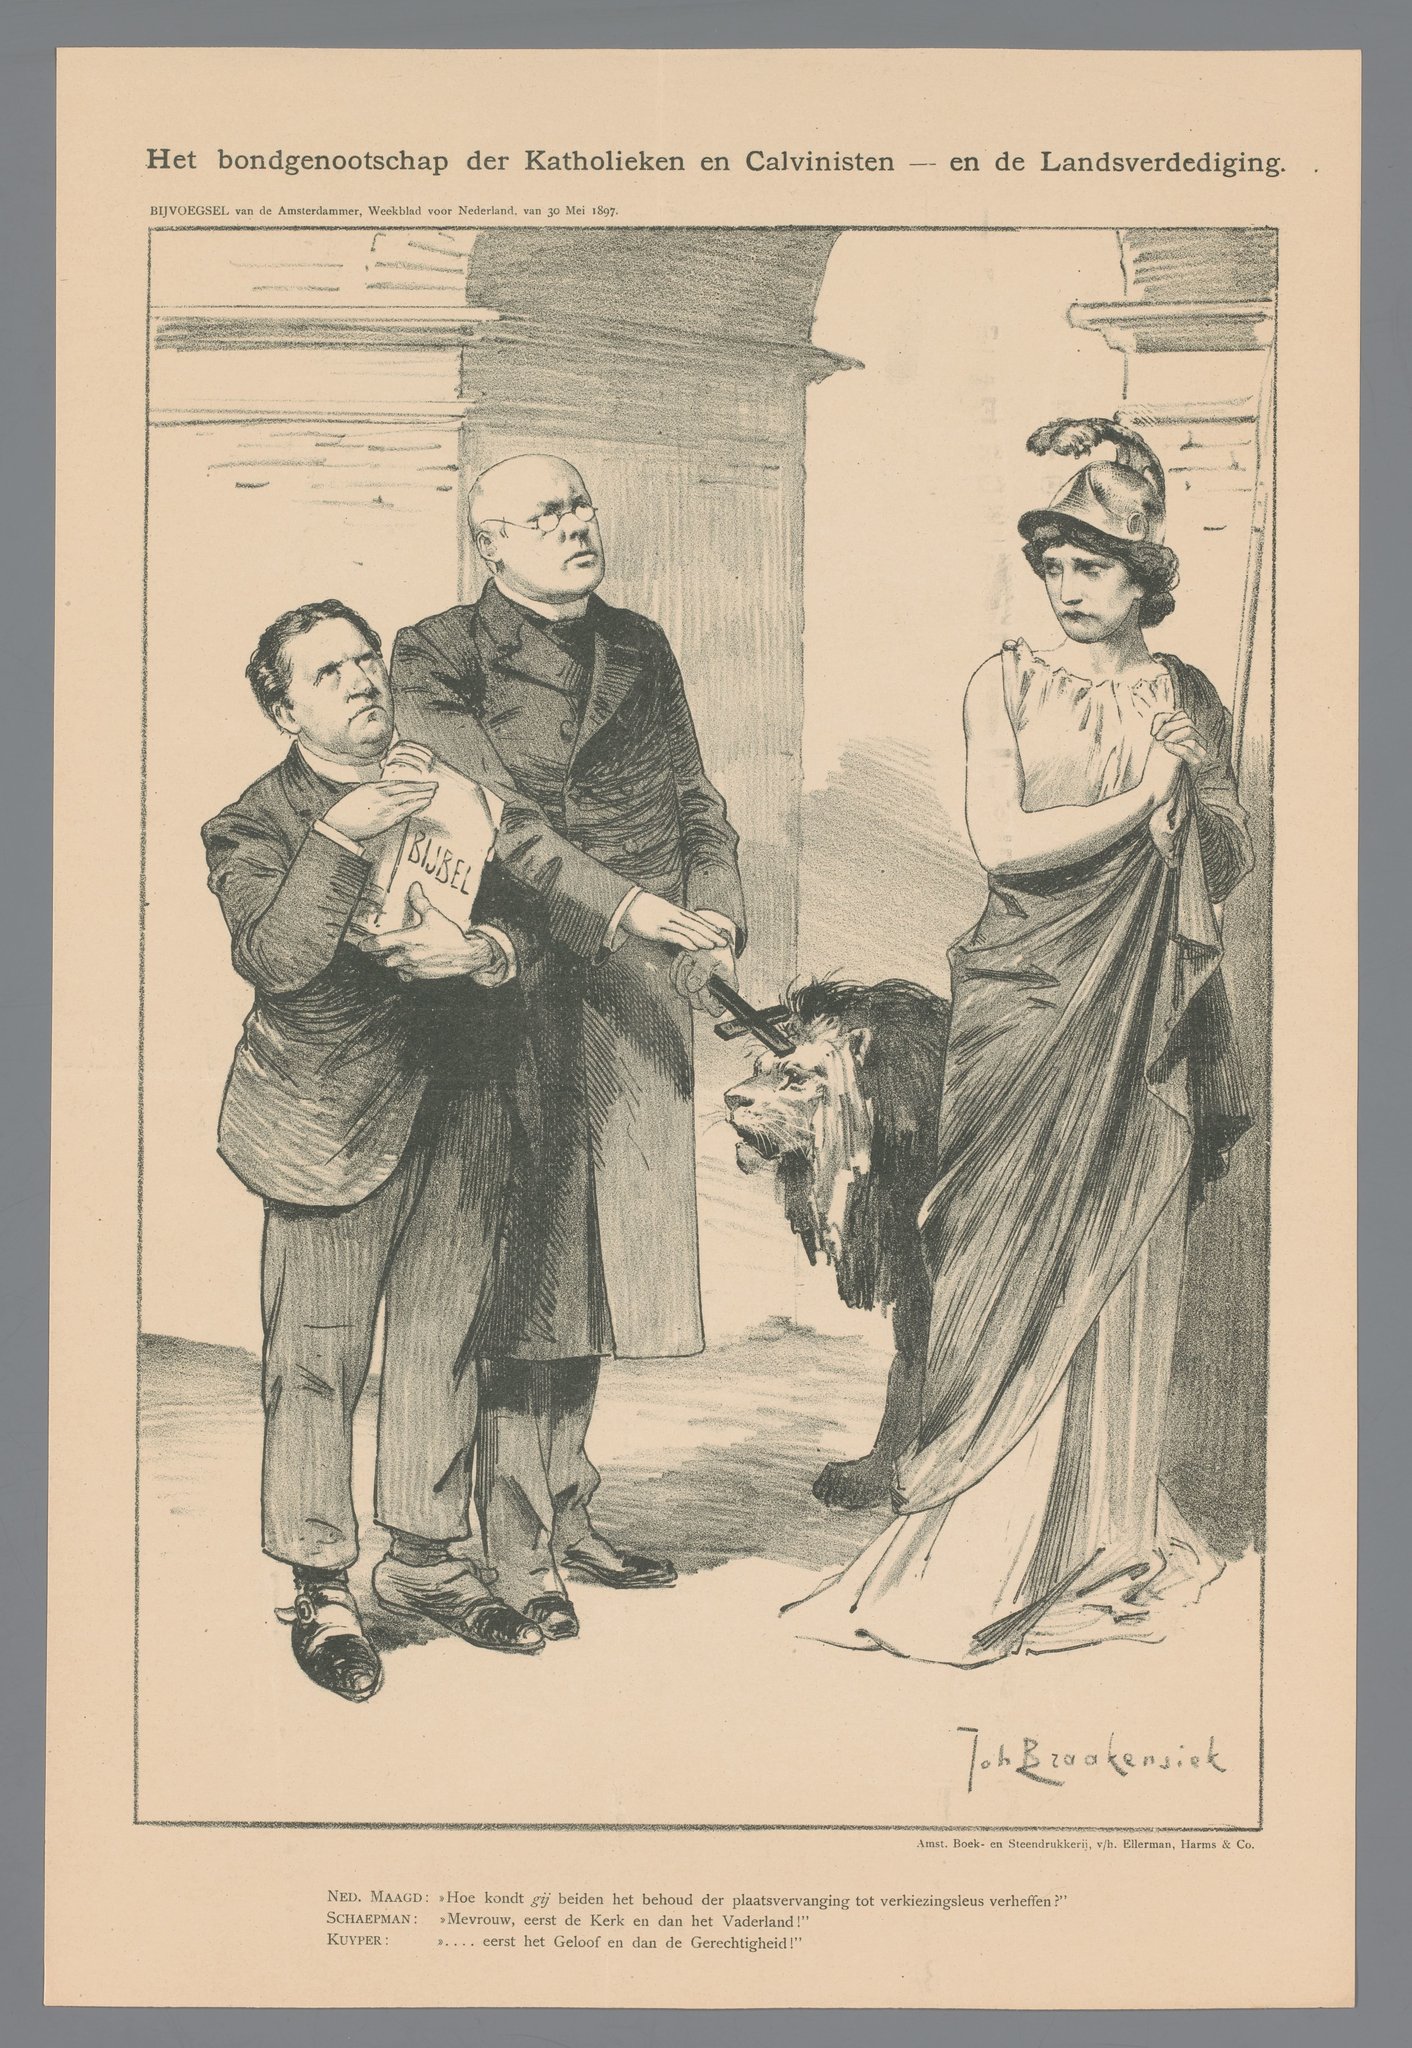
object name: cartoon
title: Het bondgenootschap der Katholieken en Calvinisten - en de Landsverdediging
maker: johan braakensiek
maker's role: draughtsman, print maker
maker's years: 1858-1940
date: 1897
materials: paper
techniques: lithograph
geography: amsterdam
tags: the hague, abraham kuyper, rome, priest, herman johannes aloysius maria schaepman, historical persons, politician, e.g. party leader, personifications of countries, nations, states, districts, etc. (+ nation; national), political caricatures and satires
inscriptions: date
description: Prent uit het bijvoegsel van: De Amsterdammer. Weekblad voor Nederland, 30 mei 1897.